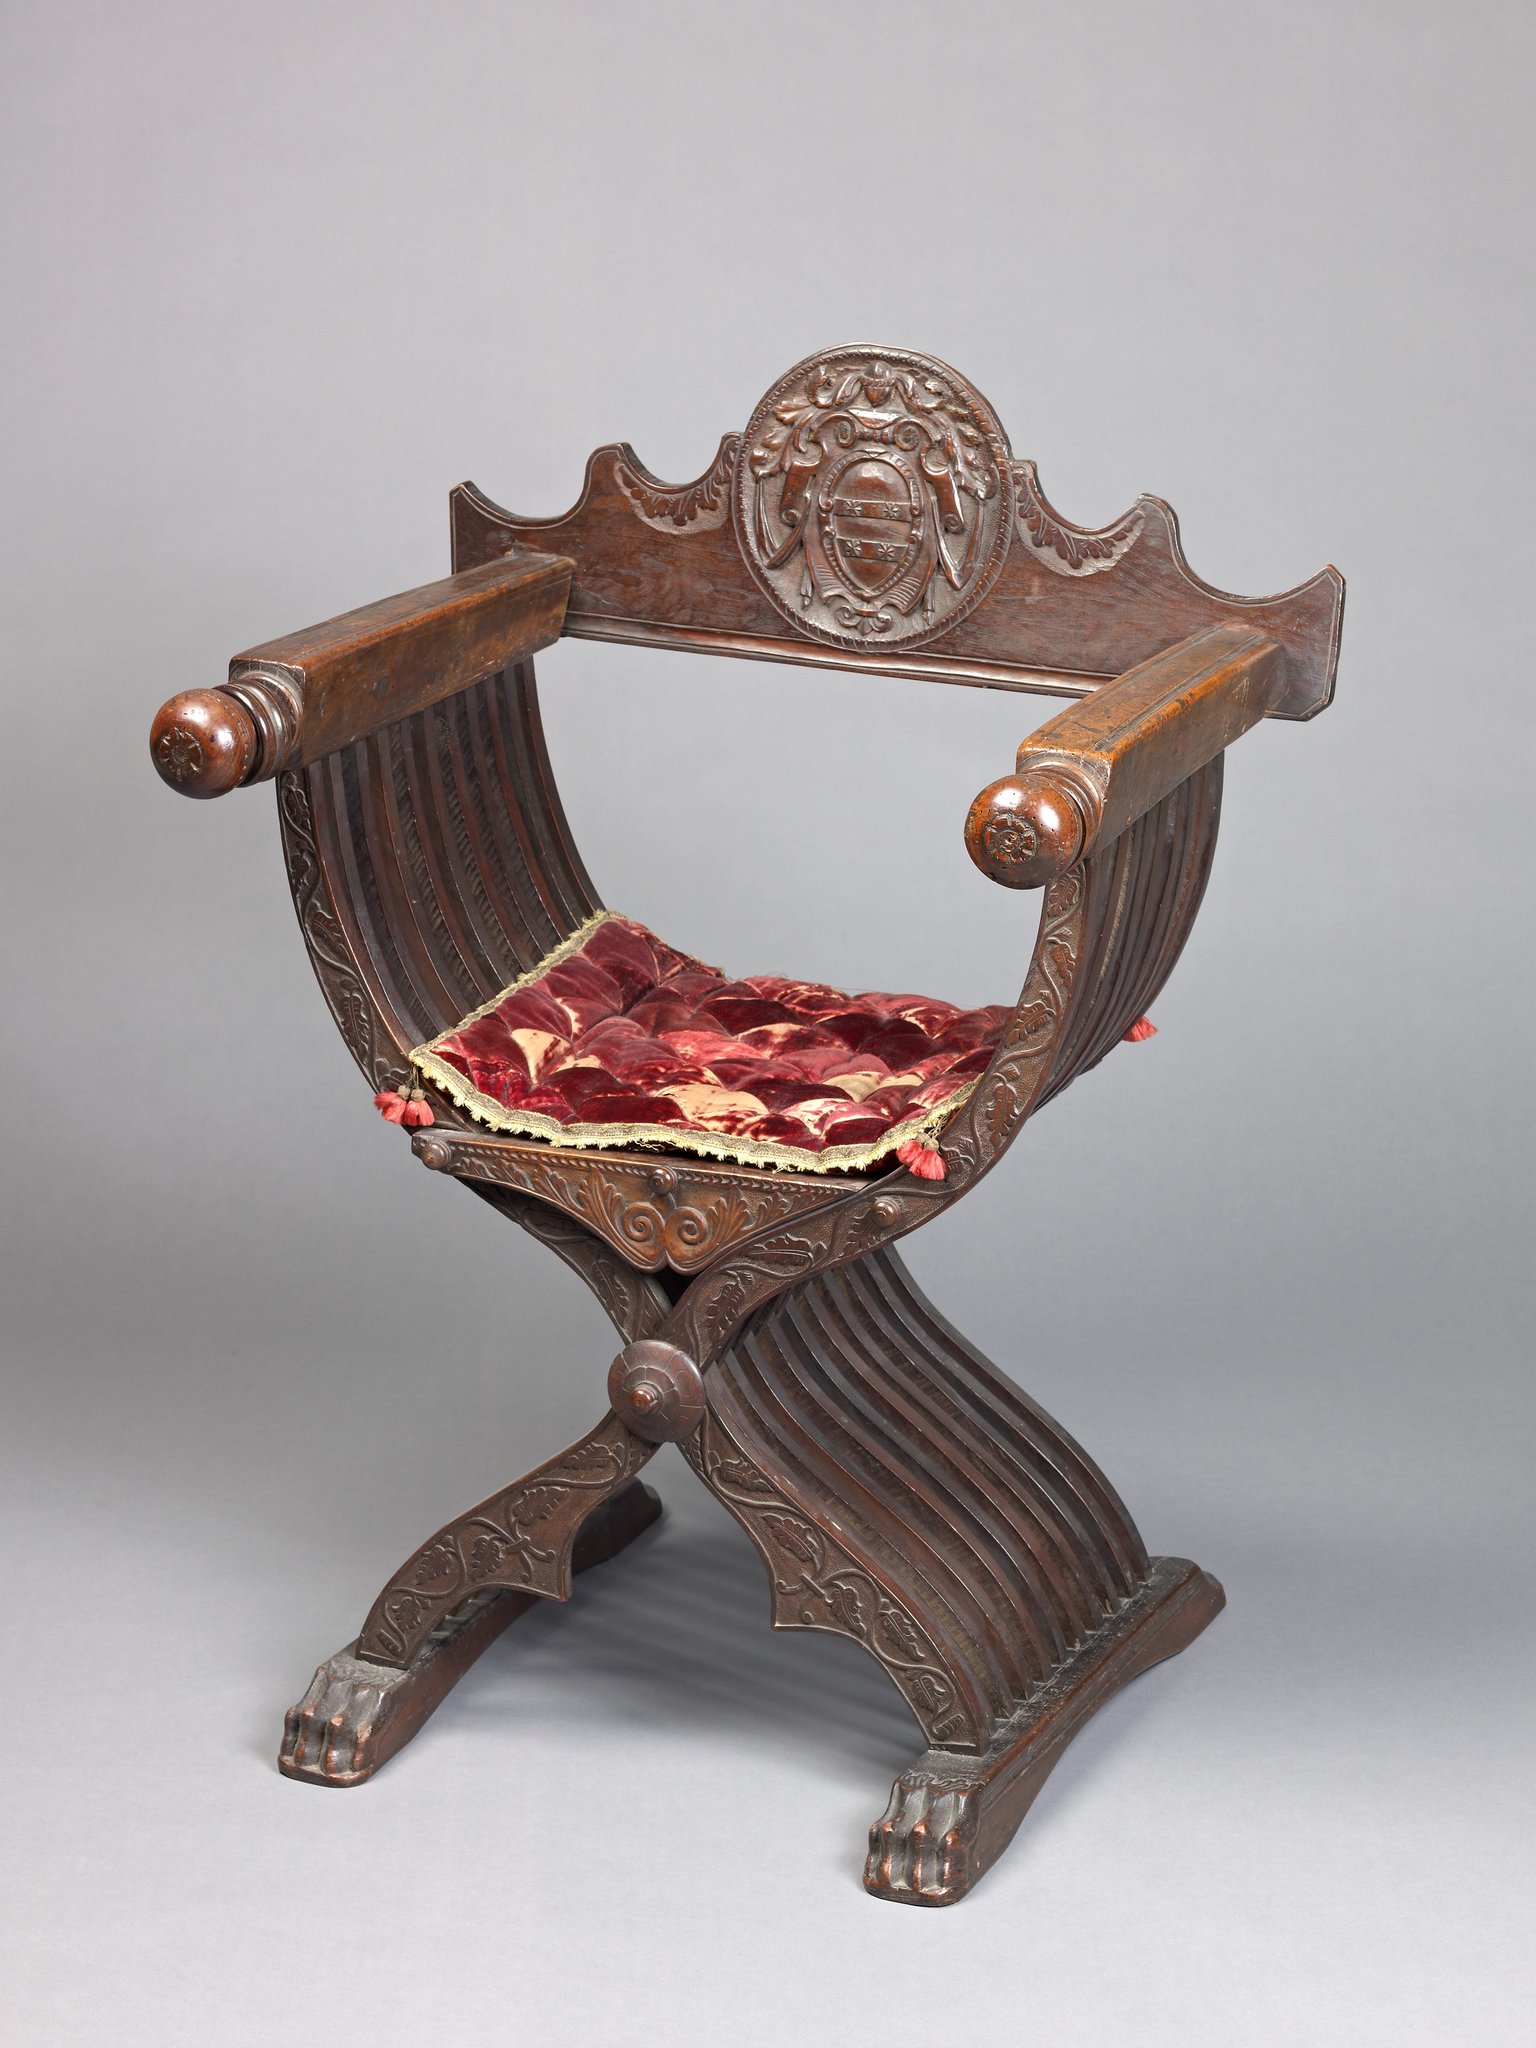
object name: armchair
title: Folding armchair (sedia a Savonarola)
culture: italian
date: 1401-1500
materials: gilt, metal, silk, velvet, wood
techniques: cutting